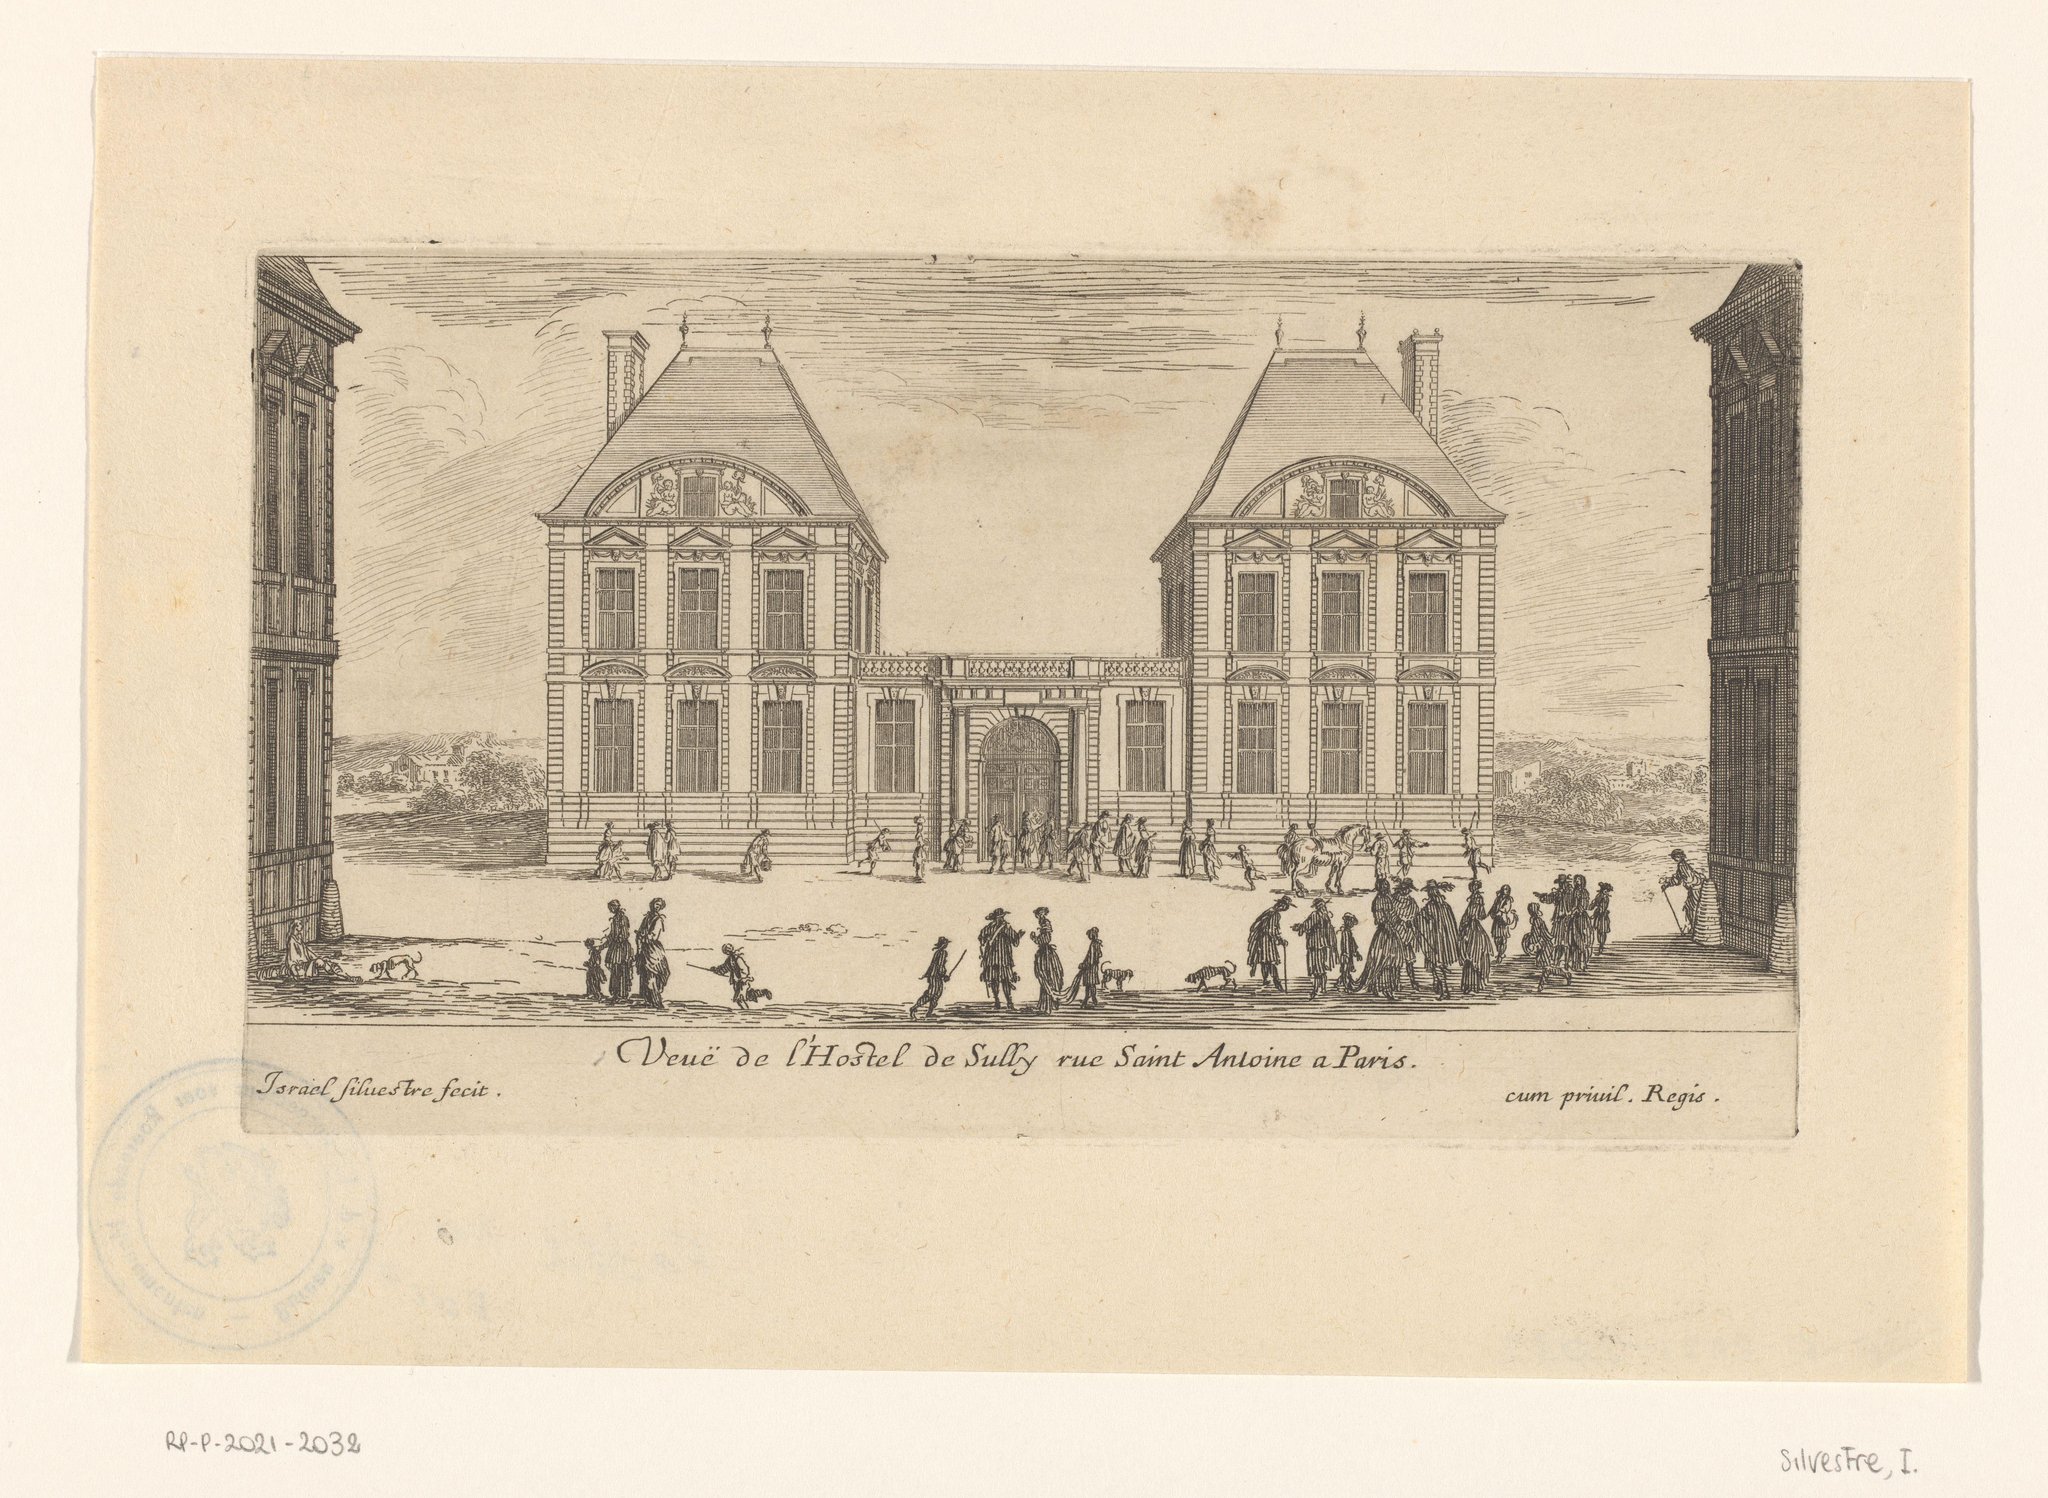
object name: print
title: Diverse gezichten op gebouwen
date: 1657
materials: paper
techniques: etching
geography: france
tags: hôtel, i.e. small palace in city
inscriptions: stamp: ‘Bureau v.d. Rijksinspecteur voor Roerende Monumenten ’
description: Prent maakt deel uit van een ongenummerde serie van negen prenten.